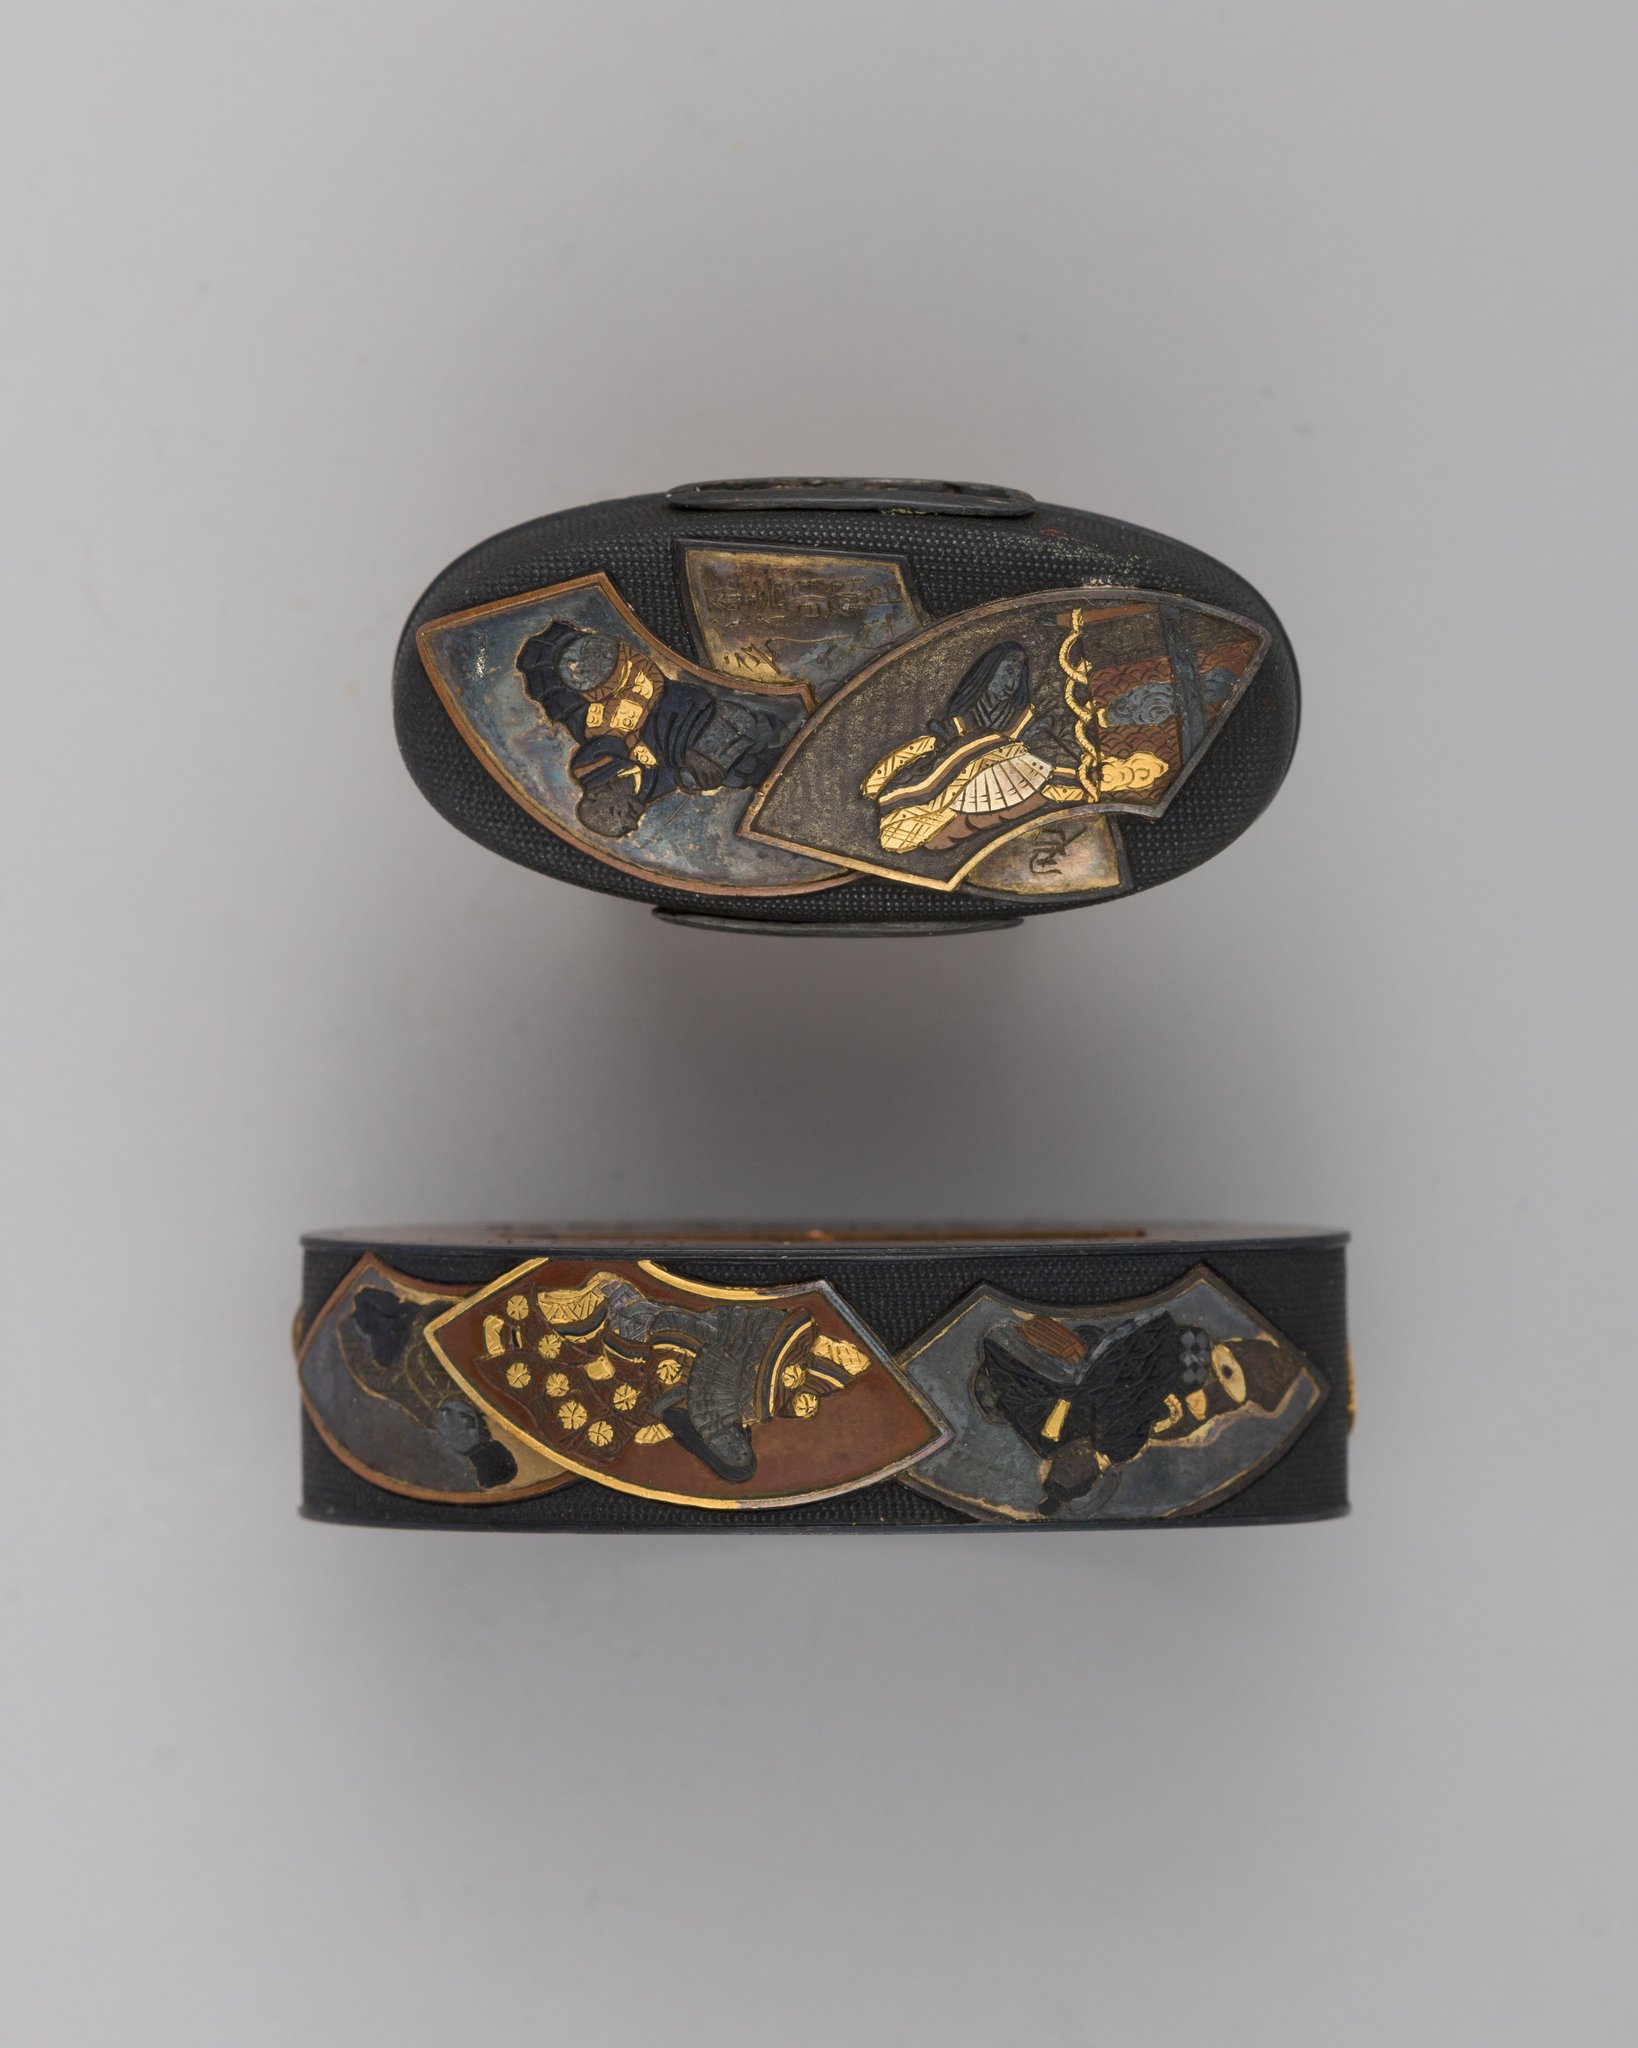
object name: sword hilt collar and pommel fuchigashira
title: Sword-Hilt Collar and Pommel (Fuchigashira)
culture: japanese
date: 1615-1868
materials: copper, gold alloy, gold, silver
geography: japan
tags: human figures